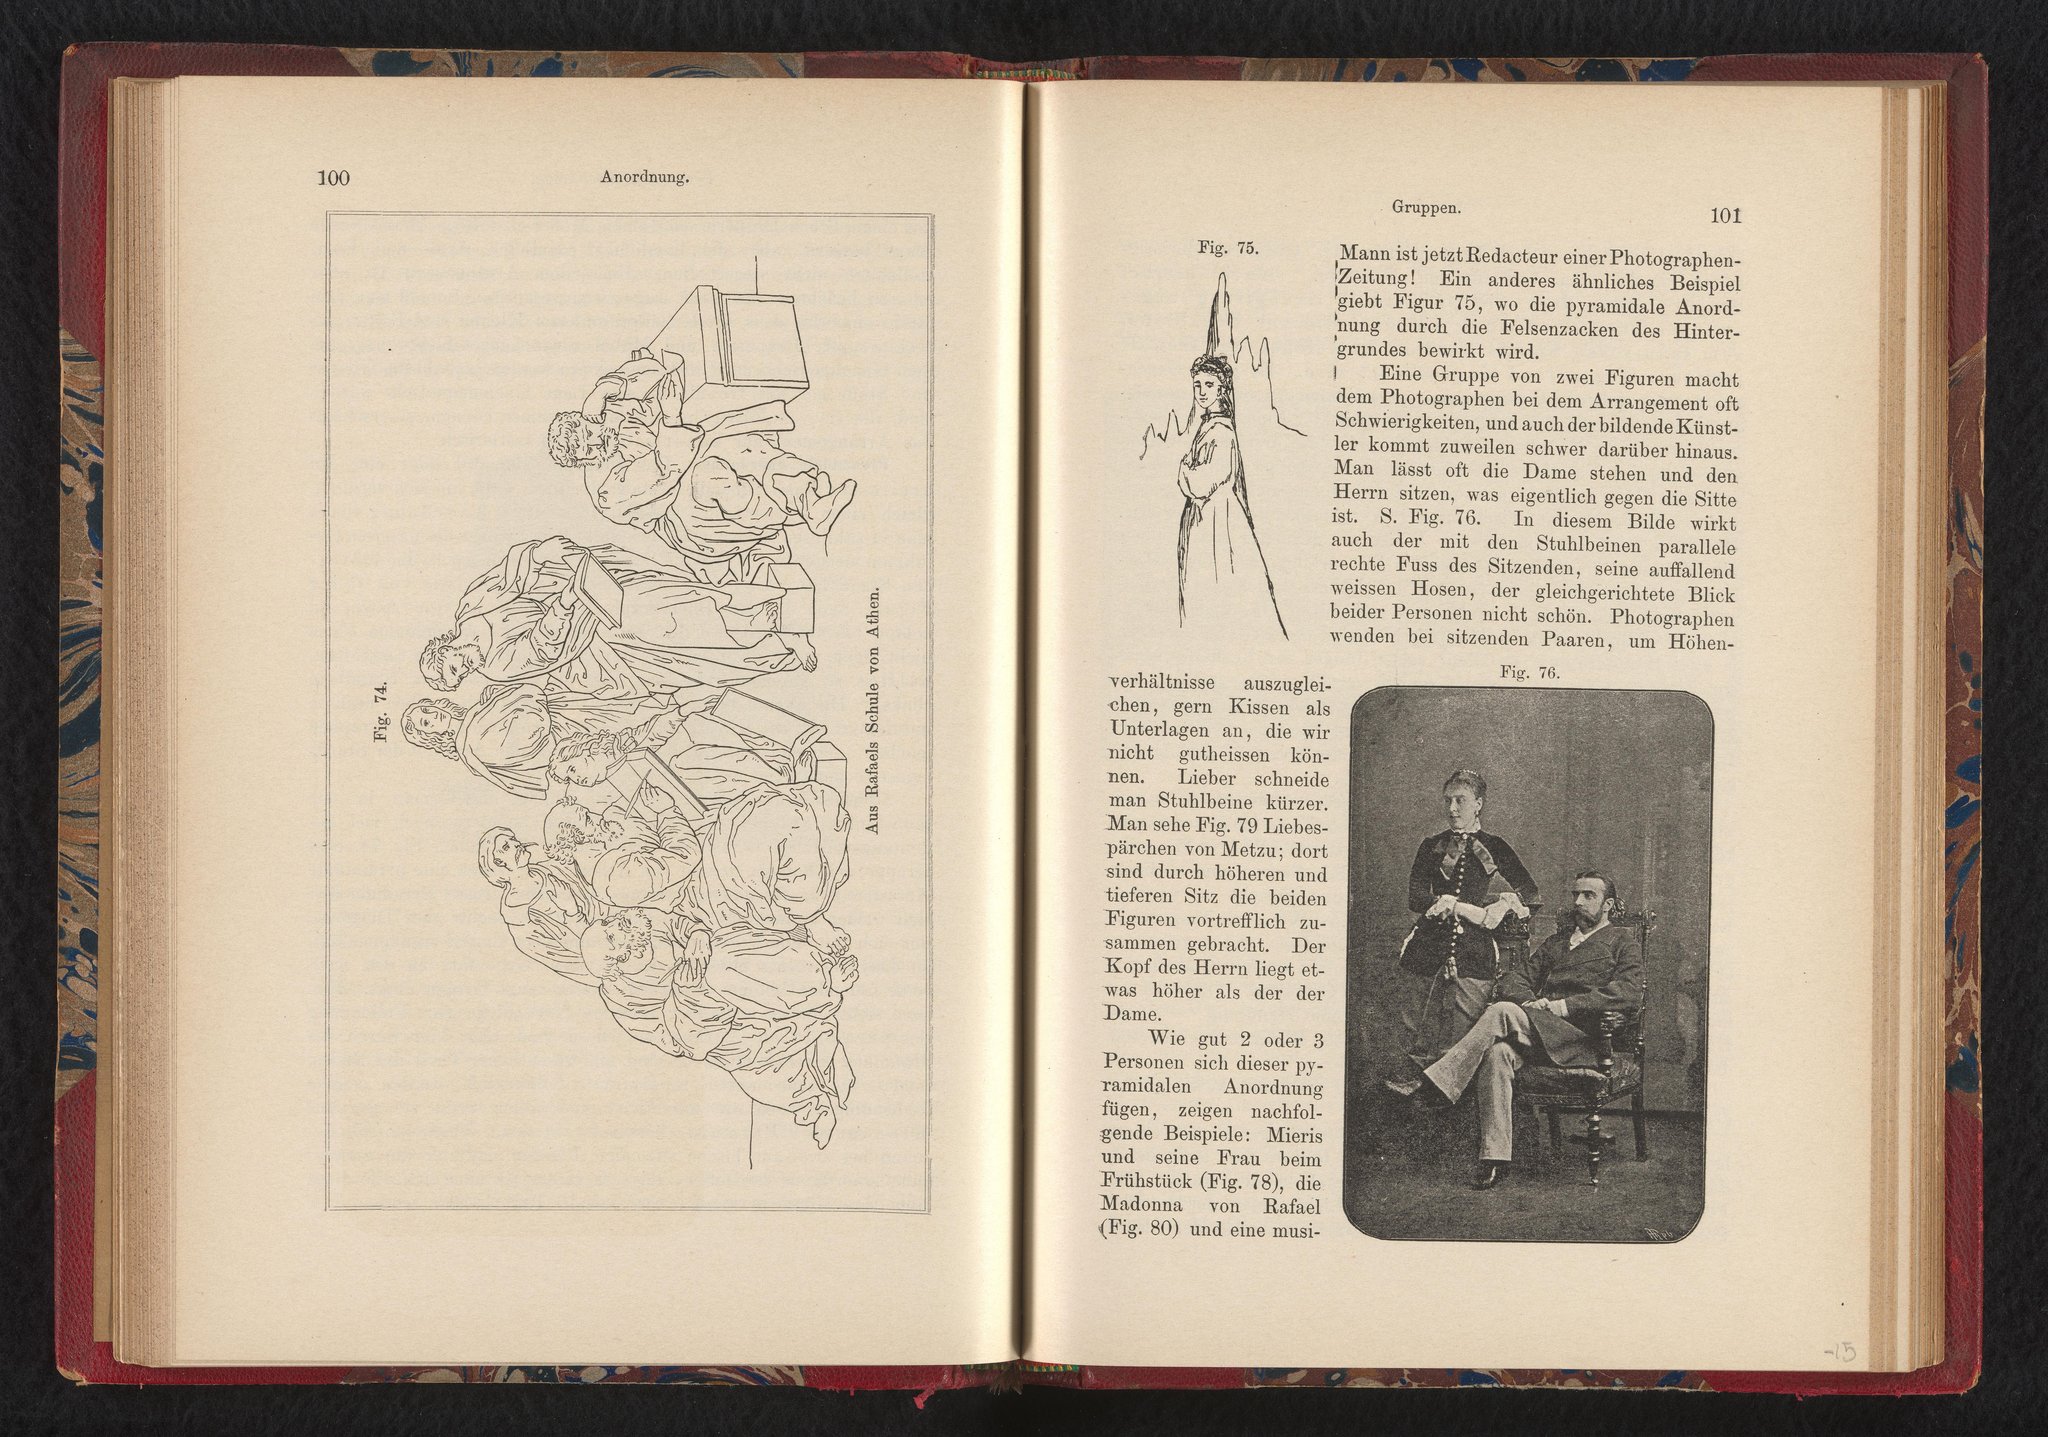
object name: photomechanical print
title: Portret van een staande vrouw en zittende man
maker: Anonymous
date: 1886-1891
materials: paper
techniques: autotype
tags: sitting figure, standing figure - aa - female human figure, relations between the sexes, historical persons not known by name